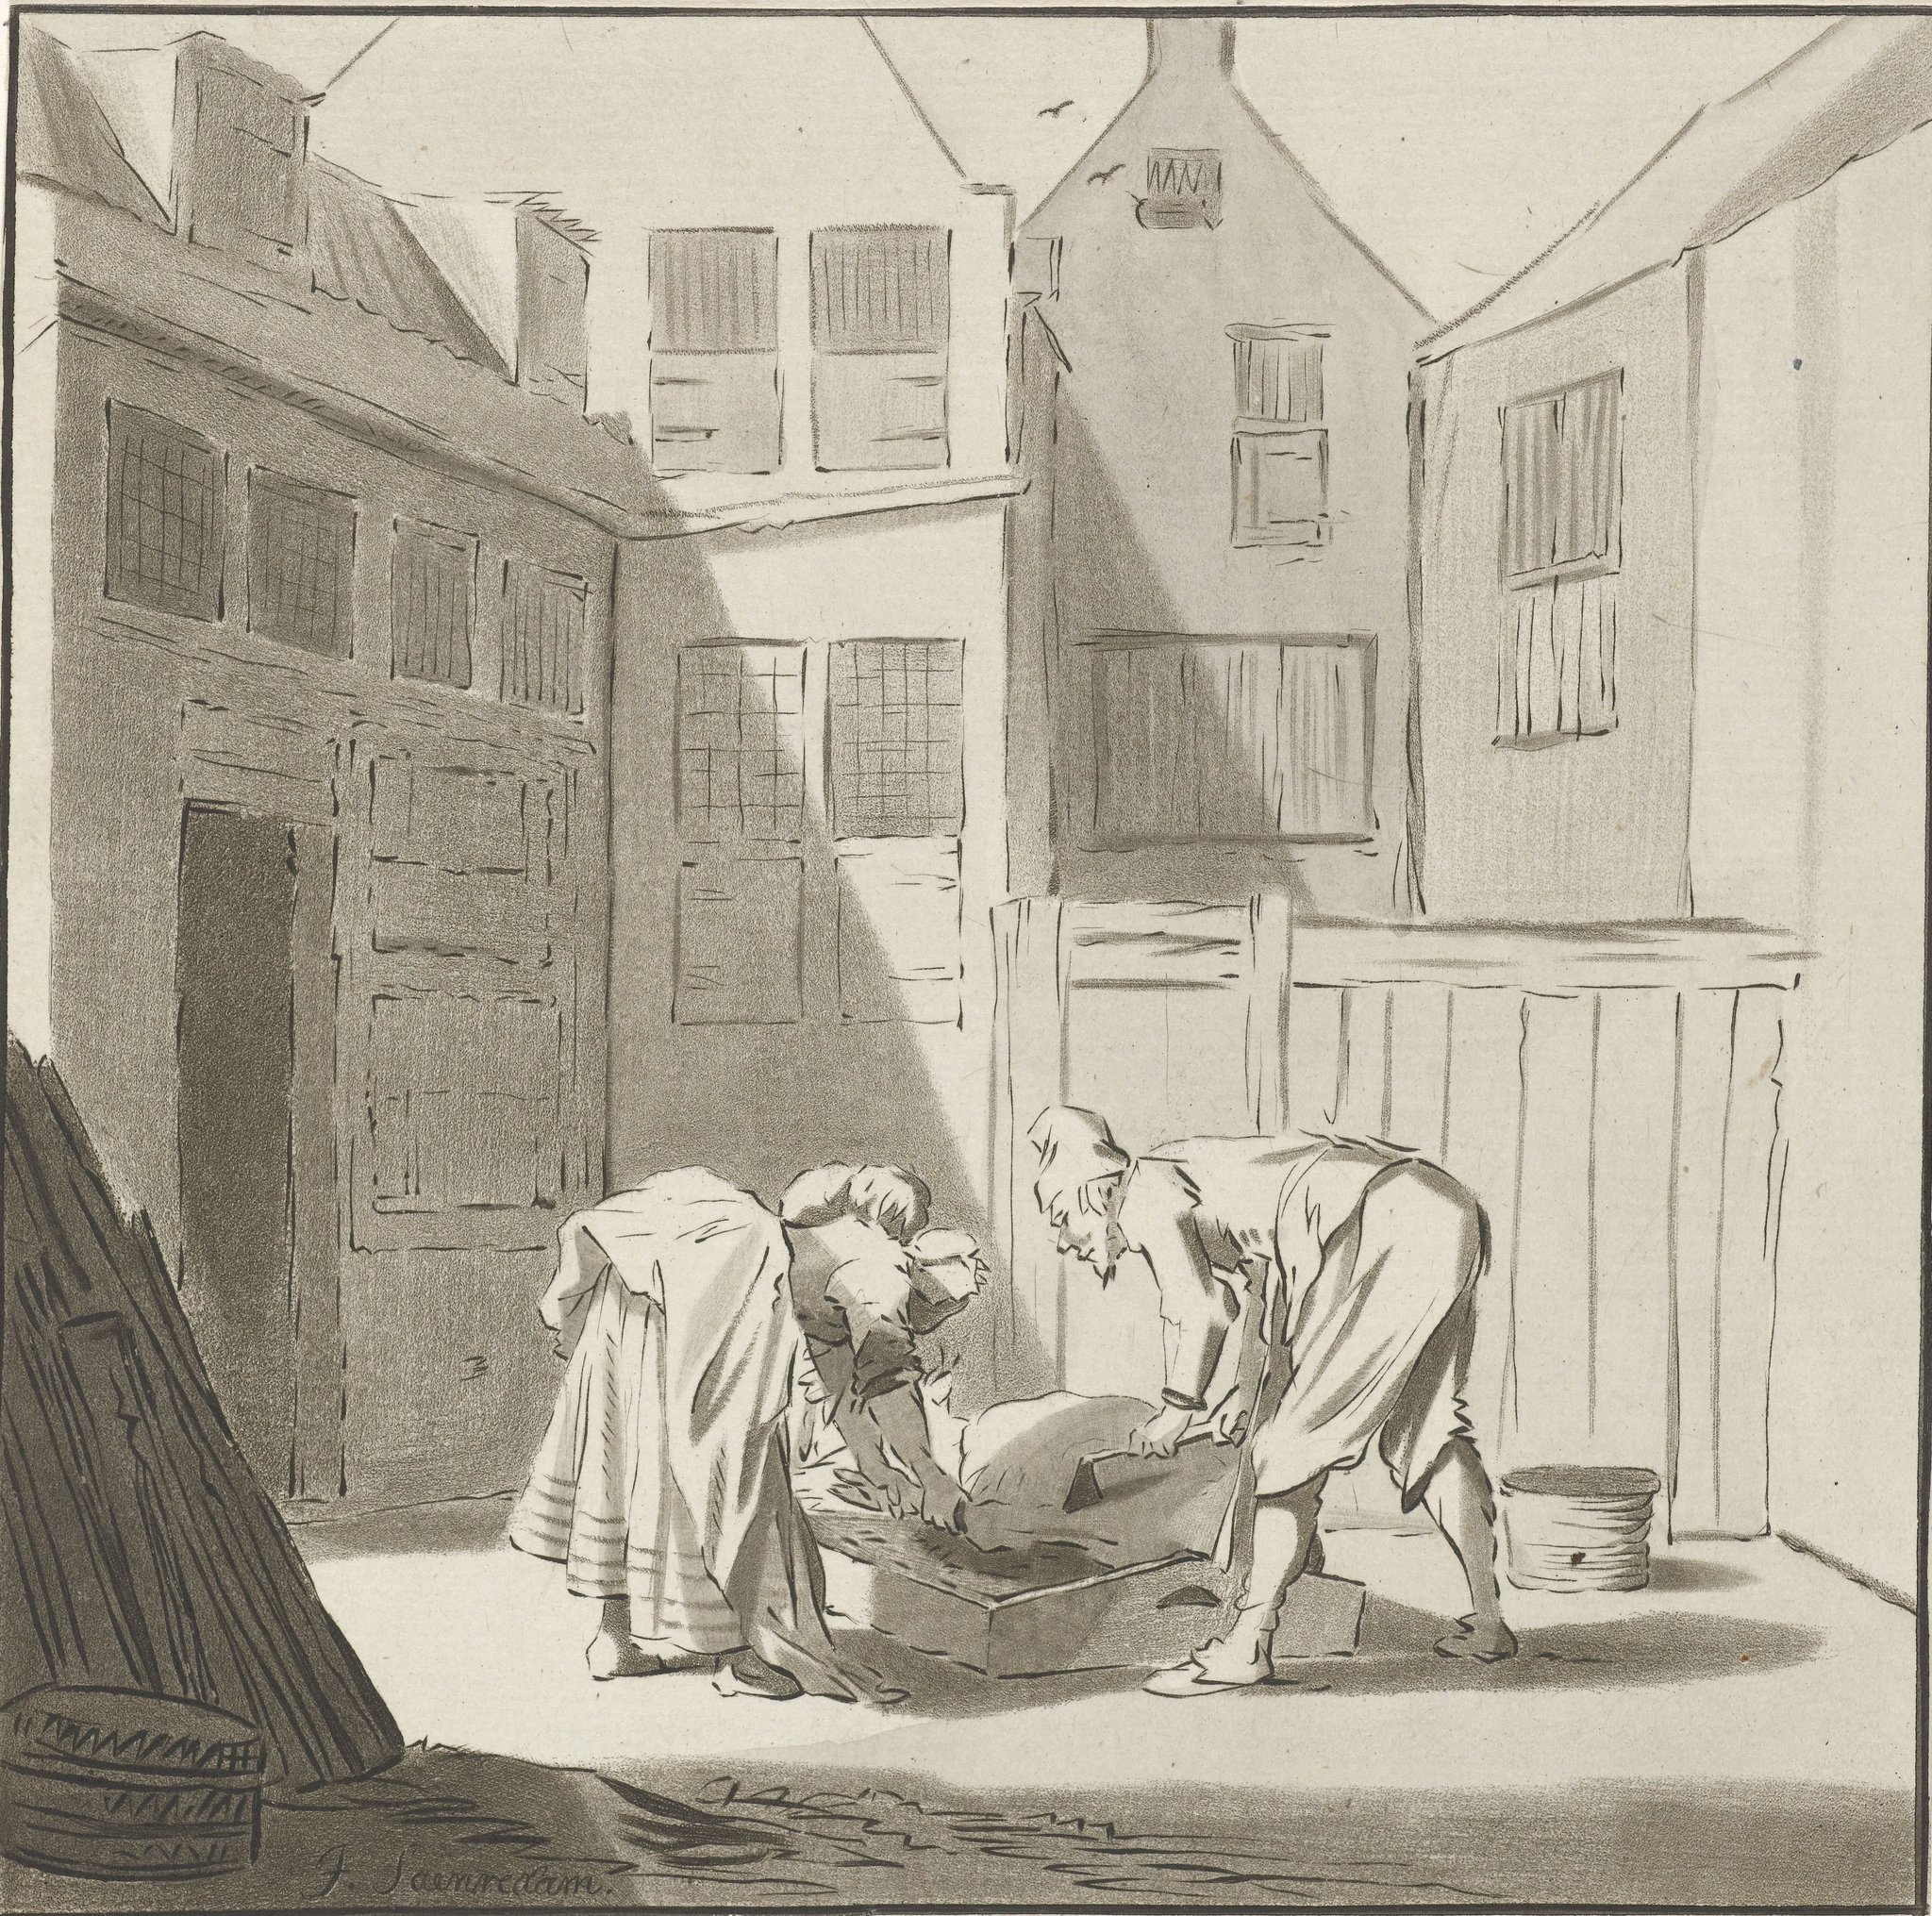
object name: print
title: Varkensslacht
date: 1778-1787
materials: paper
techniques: etching, hand coloring, roulette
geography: amsterdam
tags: slaughtered ox or pig, butcher, slaughterman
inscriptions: collector's mark: Lugt 240, inscription: ‘J. Saenredamdel 1610 pl. v. Amstel fec’, collector's mark: Lugt 2725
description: Op een binnenplaats slachten een man en een vrouw een varken.